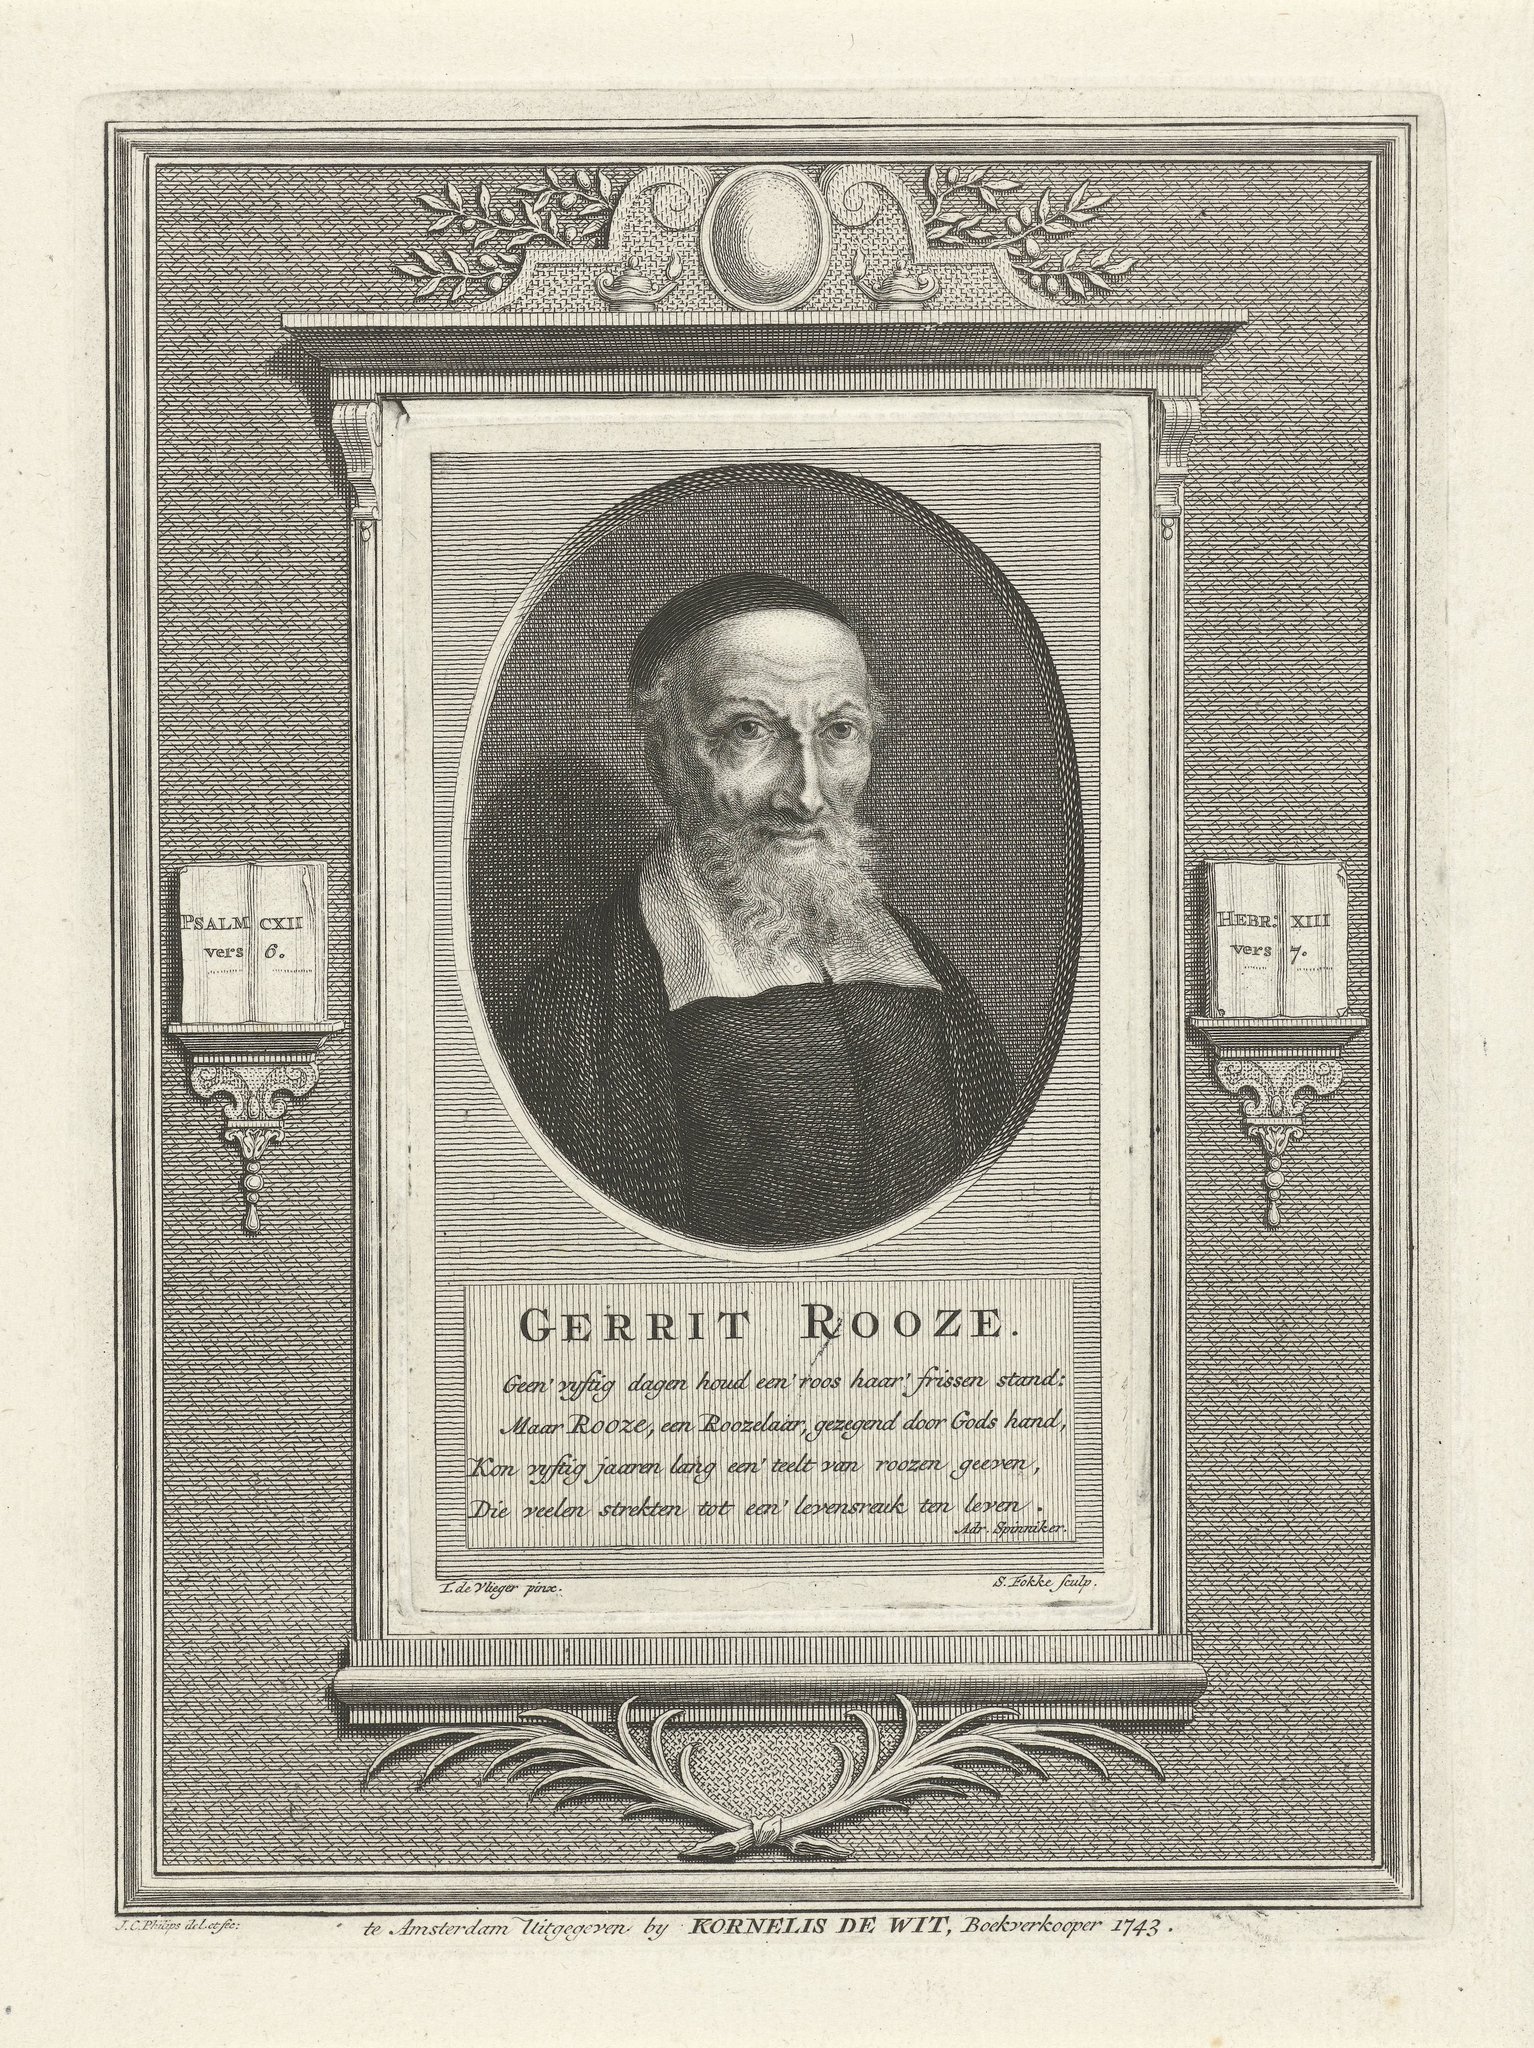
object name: print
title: Portret van Gerrit Rooze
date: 1743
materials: paper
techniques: engraving, etching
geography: amsterdam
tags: historical person (with name)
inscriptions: collector's mark: Lugt 2228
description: Portretbuste in ovaal van Gerrit Rooze, naar rechts. Onder de voorstelling staat zijn naam en een vierregelige tekst in het Nederlands. Het randwerk is afkomstig van een tweede plaat en vervaardigd door prentmaker Jan Caspar Philips.